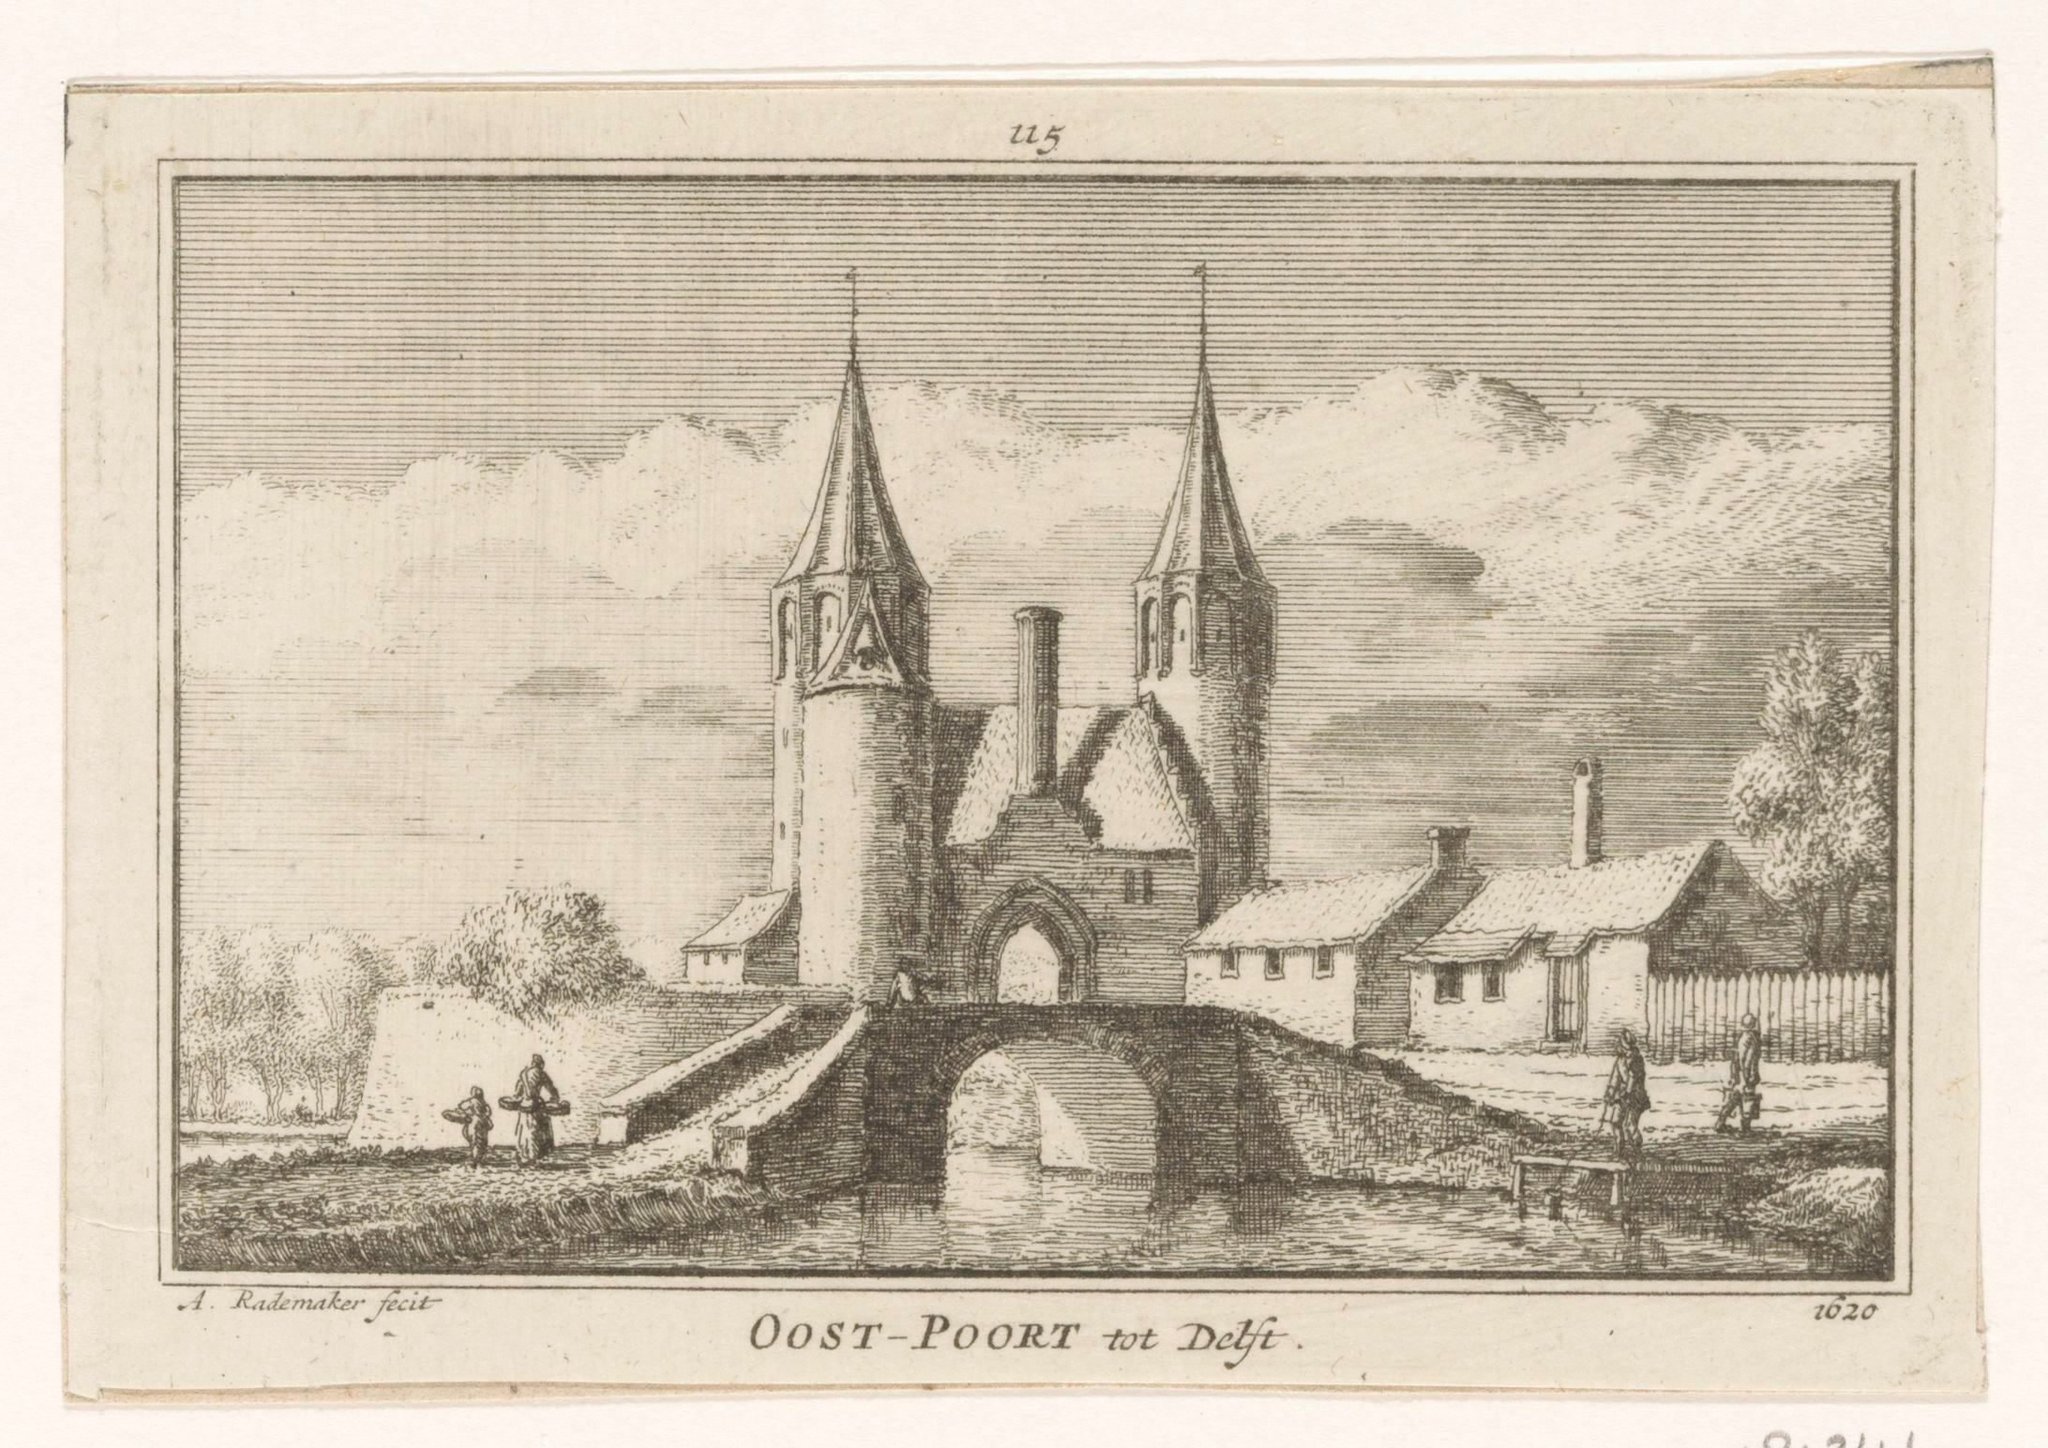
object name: print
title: Gezicht op de Oostpoort te Delft, 1620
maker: abraham rademaker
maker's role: draughtsman, print maker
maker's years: 1676-1735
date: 1725-1803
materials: paper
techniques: engraving, etching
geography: amsterdam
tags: city-gate, fisherman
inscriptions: collector's mark: Lugt 2228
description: Prent ook gebruikt in: Rademaker, Abraham. Kabinet van Nederlandsche outheden en gezichten: vervat in 300 konstplaaten (…). 2 delen. Amsterdam: Willem Barents, 1725, dl. 1, ill. 115. Na 1725 is deze prent nog in verschillende heruitgaven verschenen, uitgegeven in 1727-1733, 1770-1771 en 1792-1803. Uit welke uitgave het huidige exemplaar precies komt is niet na te gaan.